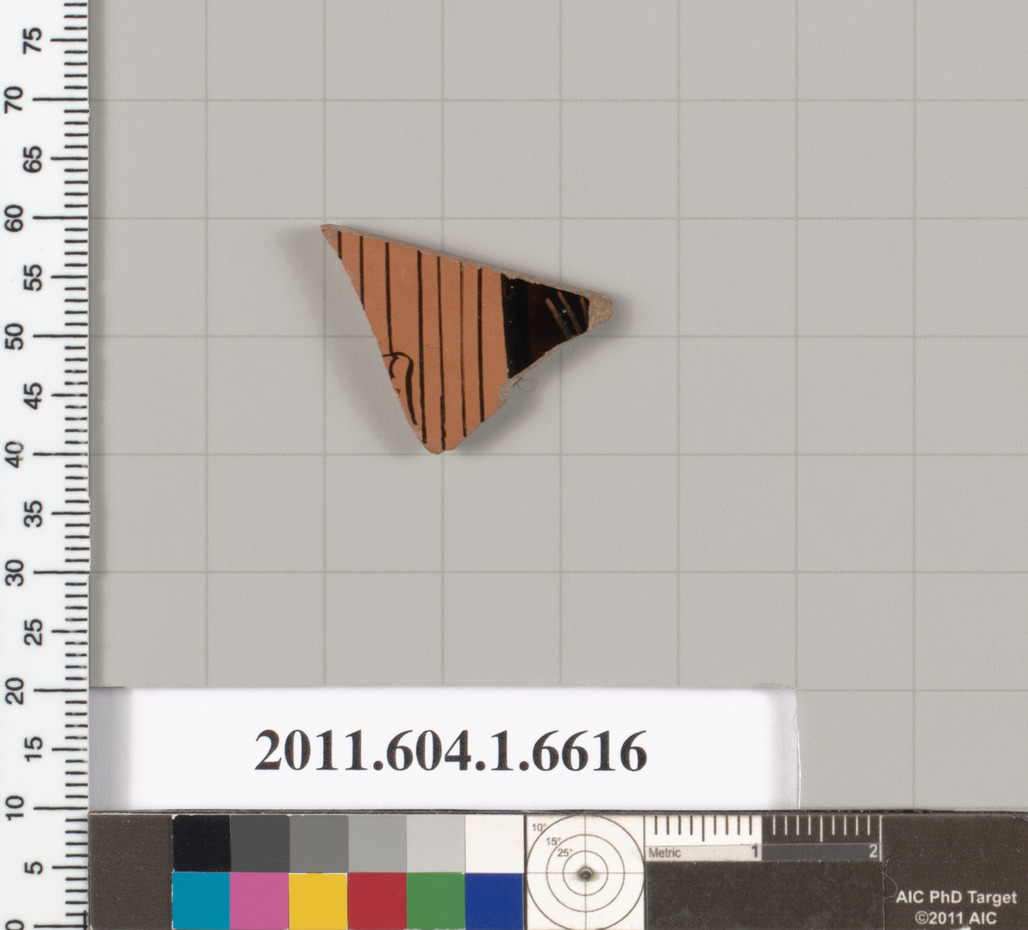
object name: kylix fragment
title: Terracotta fragment of a kylix (drinking cup)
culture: greek, attic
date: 490-470 BCE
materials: terracotta